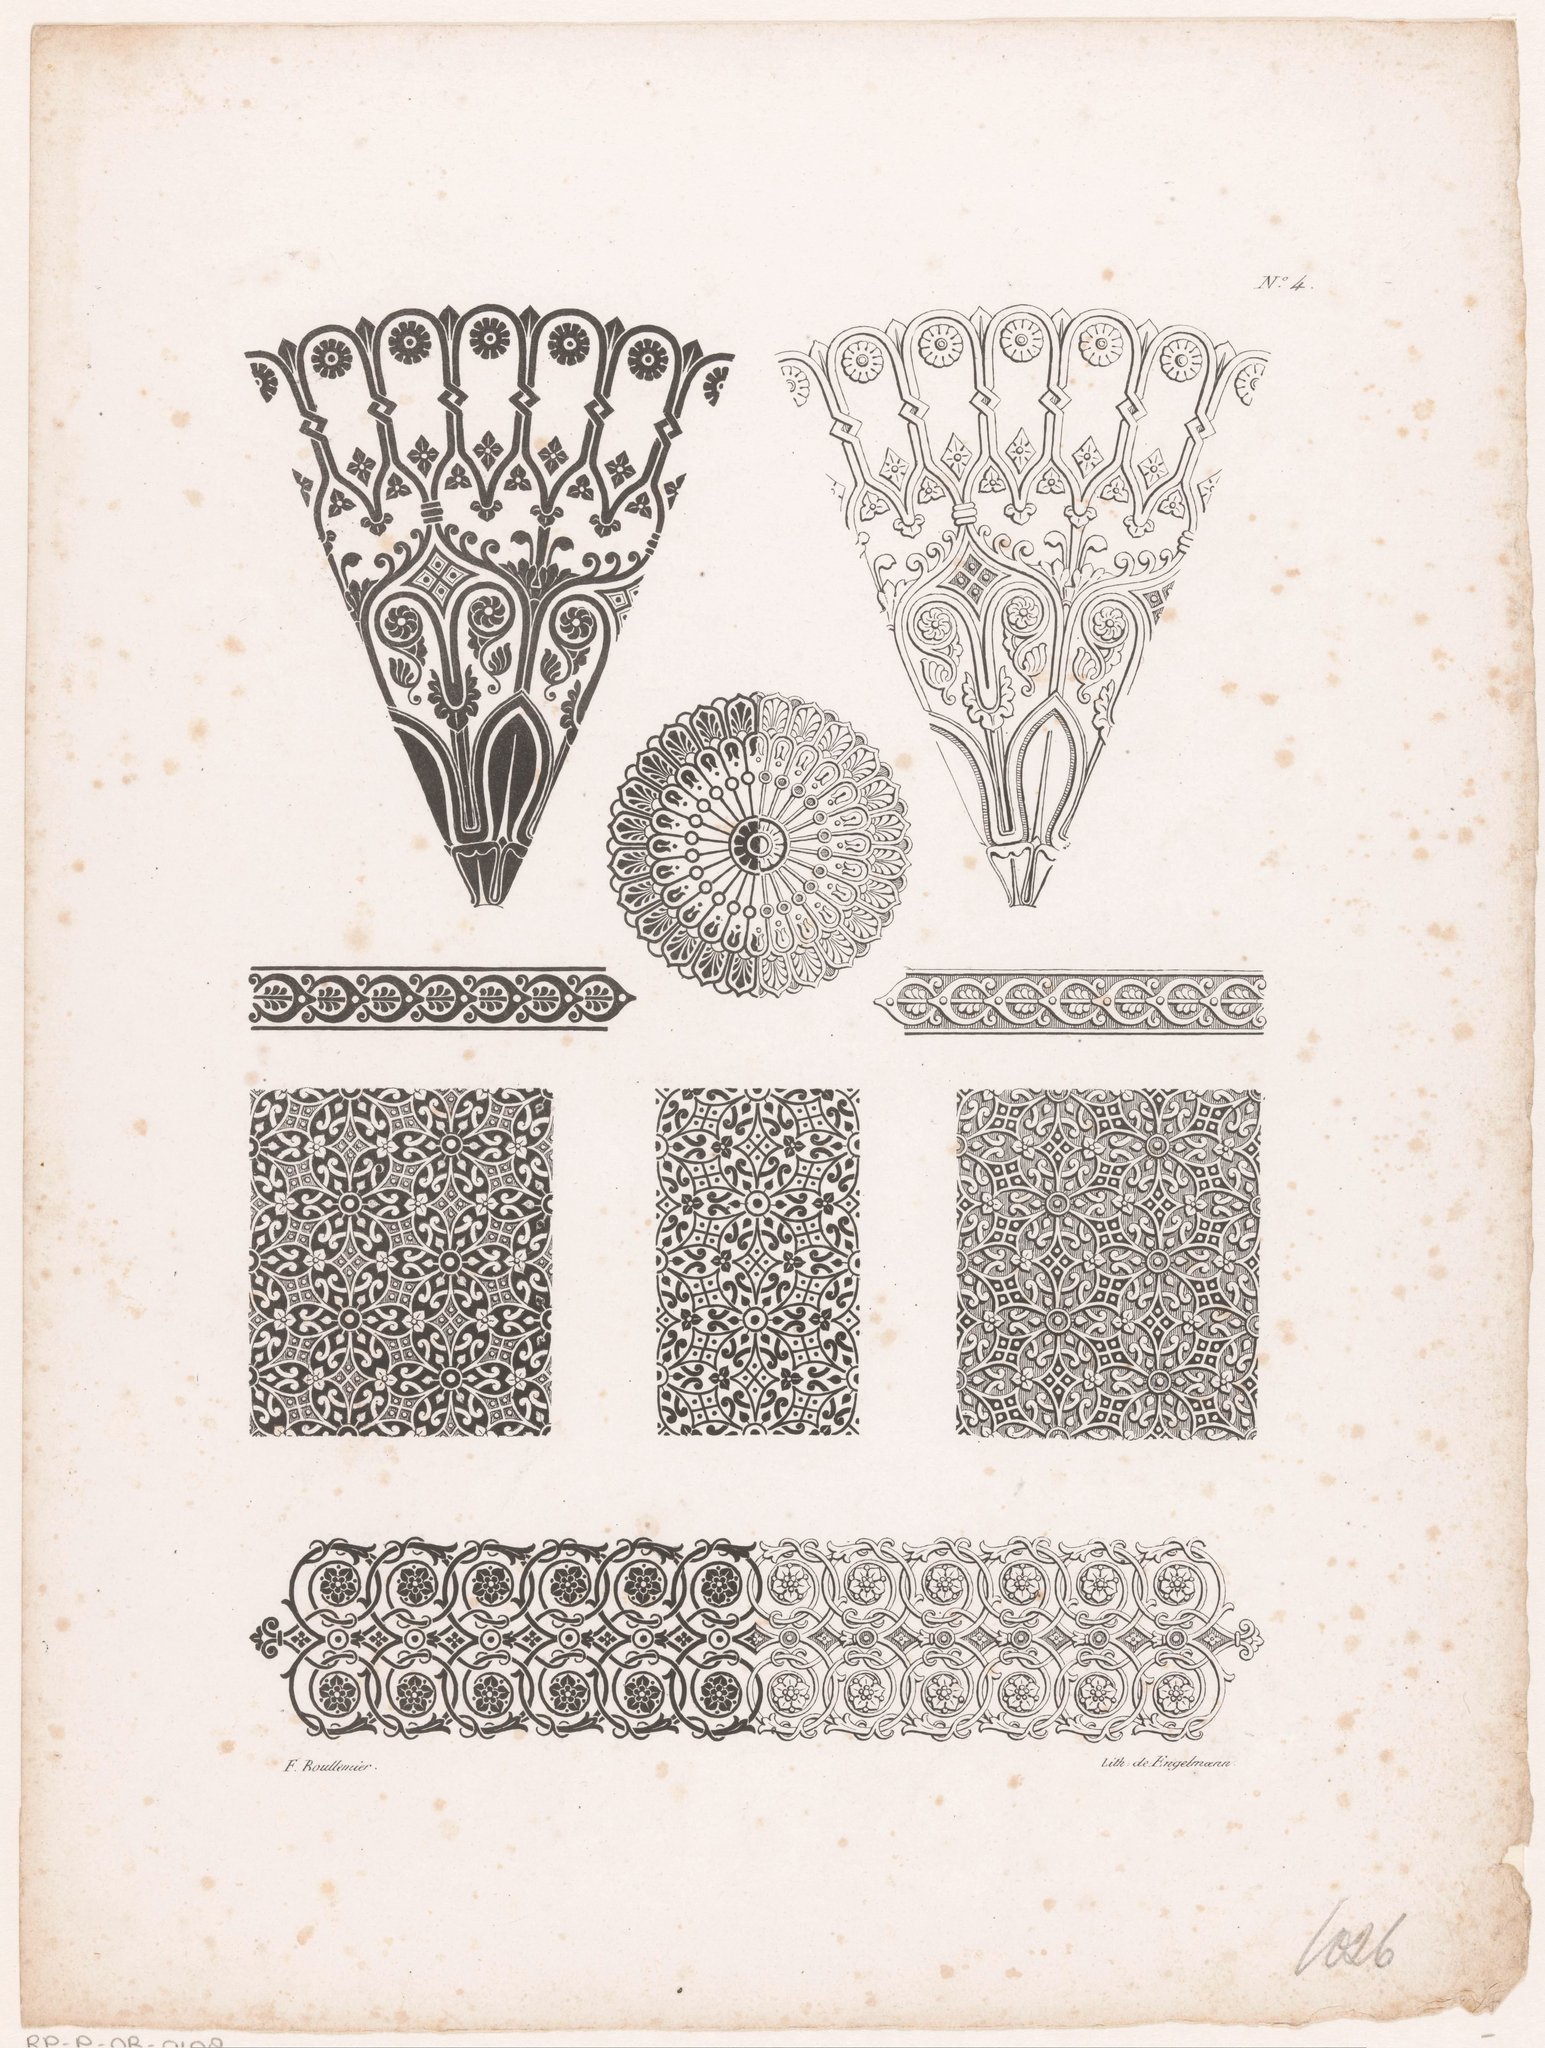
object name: print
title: Waaiervormige en vierkante ornamenten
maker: f. boullemier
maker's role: print maker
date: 1798-1839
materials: paper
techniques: lithograph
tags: ornaments ~ art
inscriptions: collector's mark: Lugt 2228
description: Twee waaiervormige, een rond en twee vierkante ornamenten en drie geornamenteerde lijsten met bladmotieven.